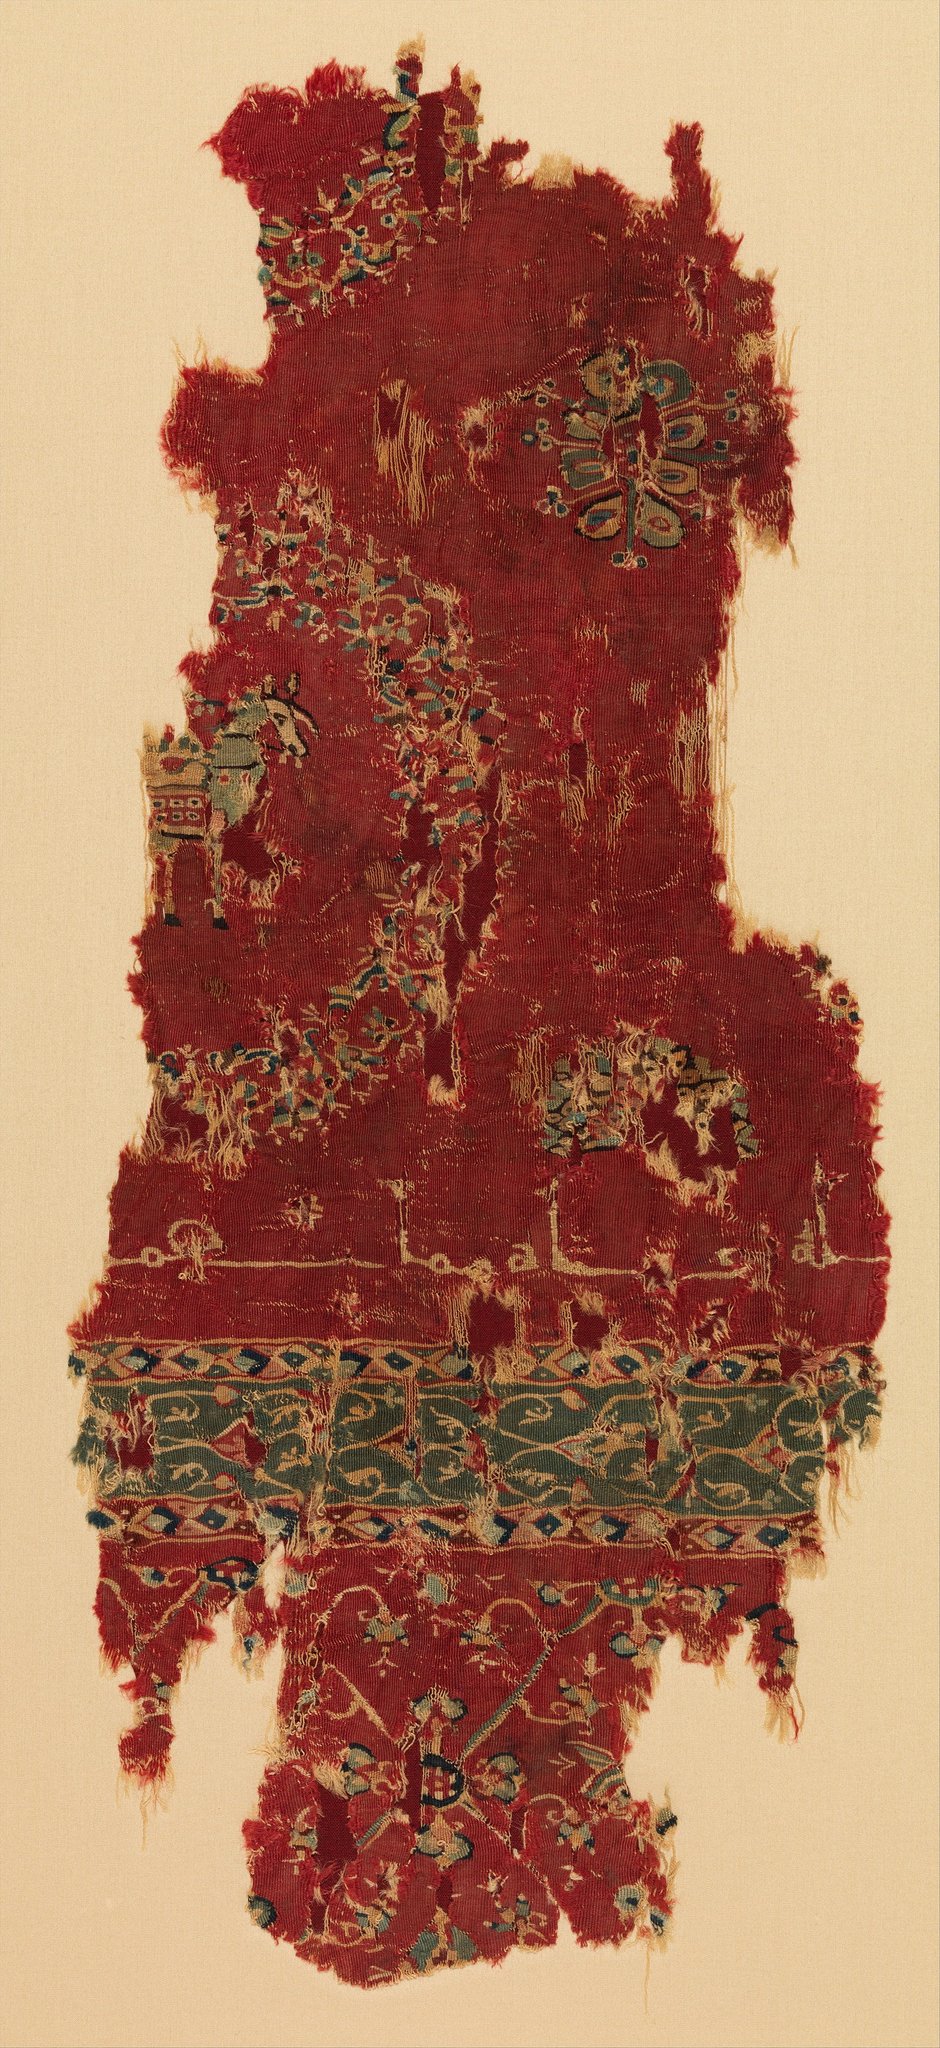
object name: fragment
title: Tapestry-Woven Fragment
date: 701-800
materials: wool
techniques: tapestry weave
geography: iraq